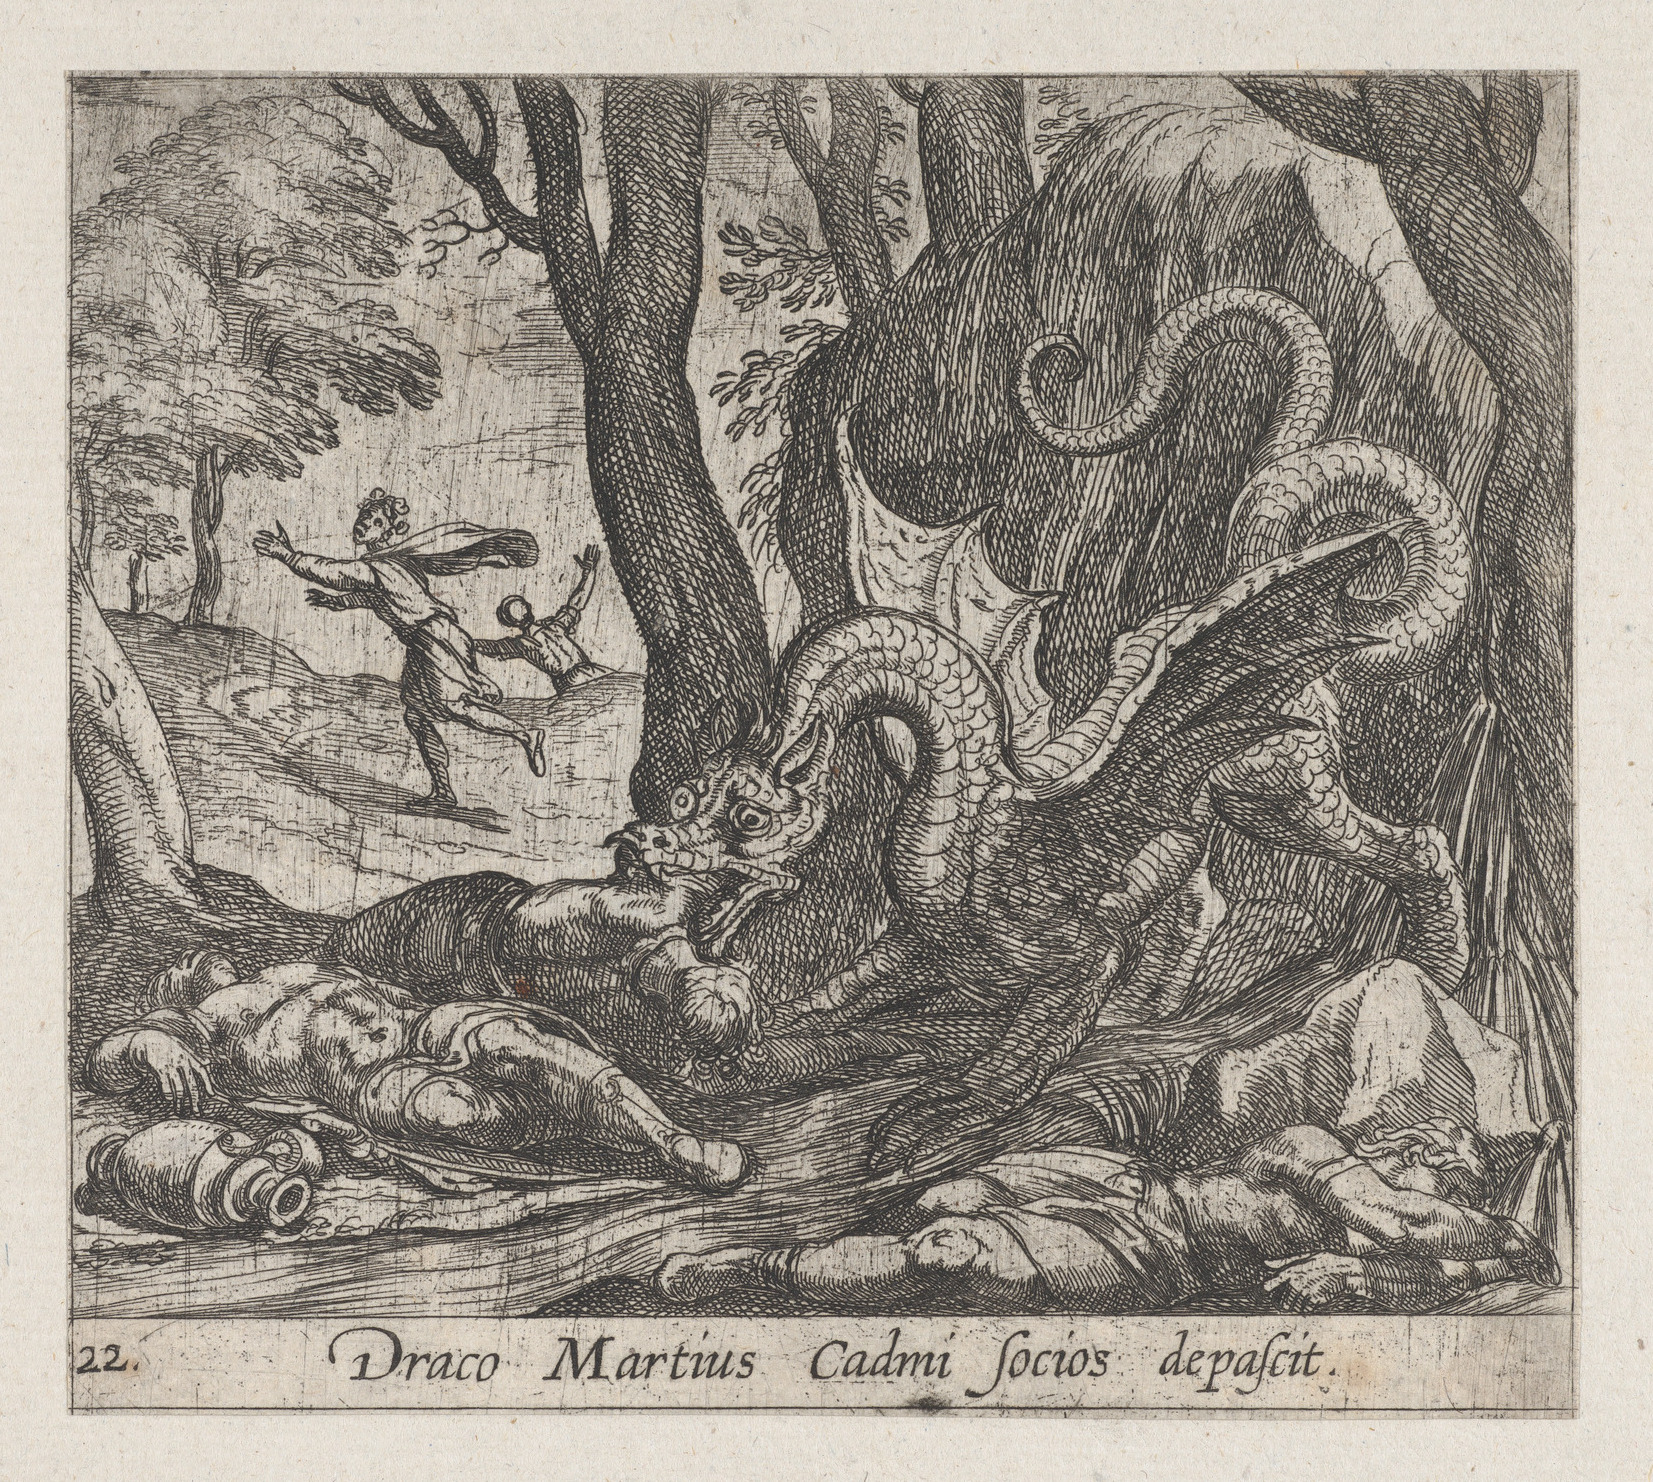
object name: print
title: Plate 22: Cadmus's Men Killed by the Serpent (Draco Martius Cadmi socios depascit), from Ovid's 'Metamorphoses'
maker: antonio tempesta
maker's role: artist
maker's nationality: italian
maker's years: 1555-1630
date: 1606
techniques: etching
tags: men,death